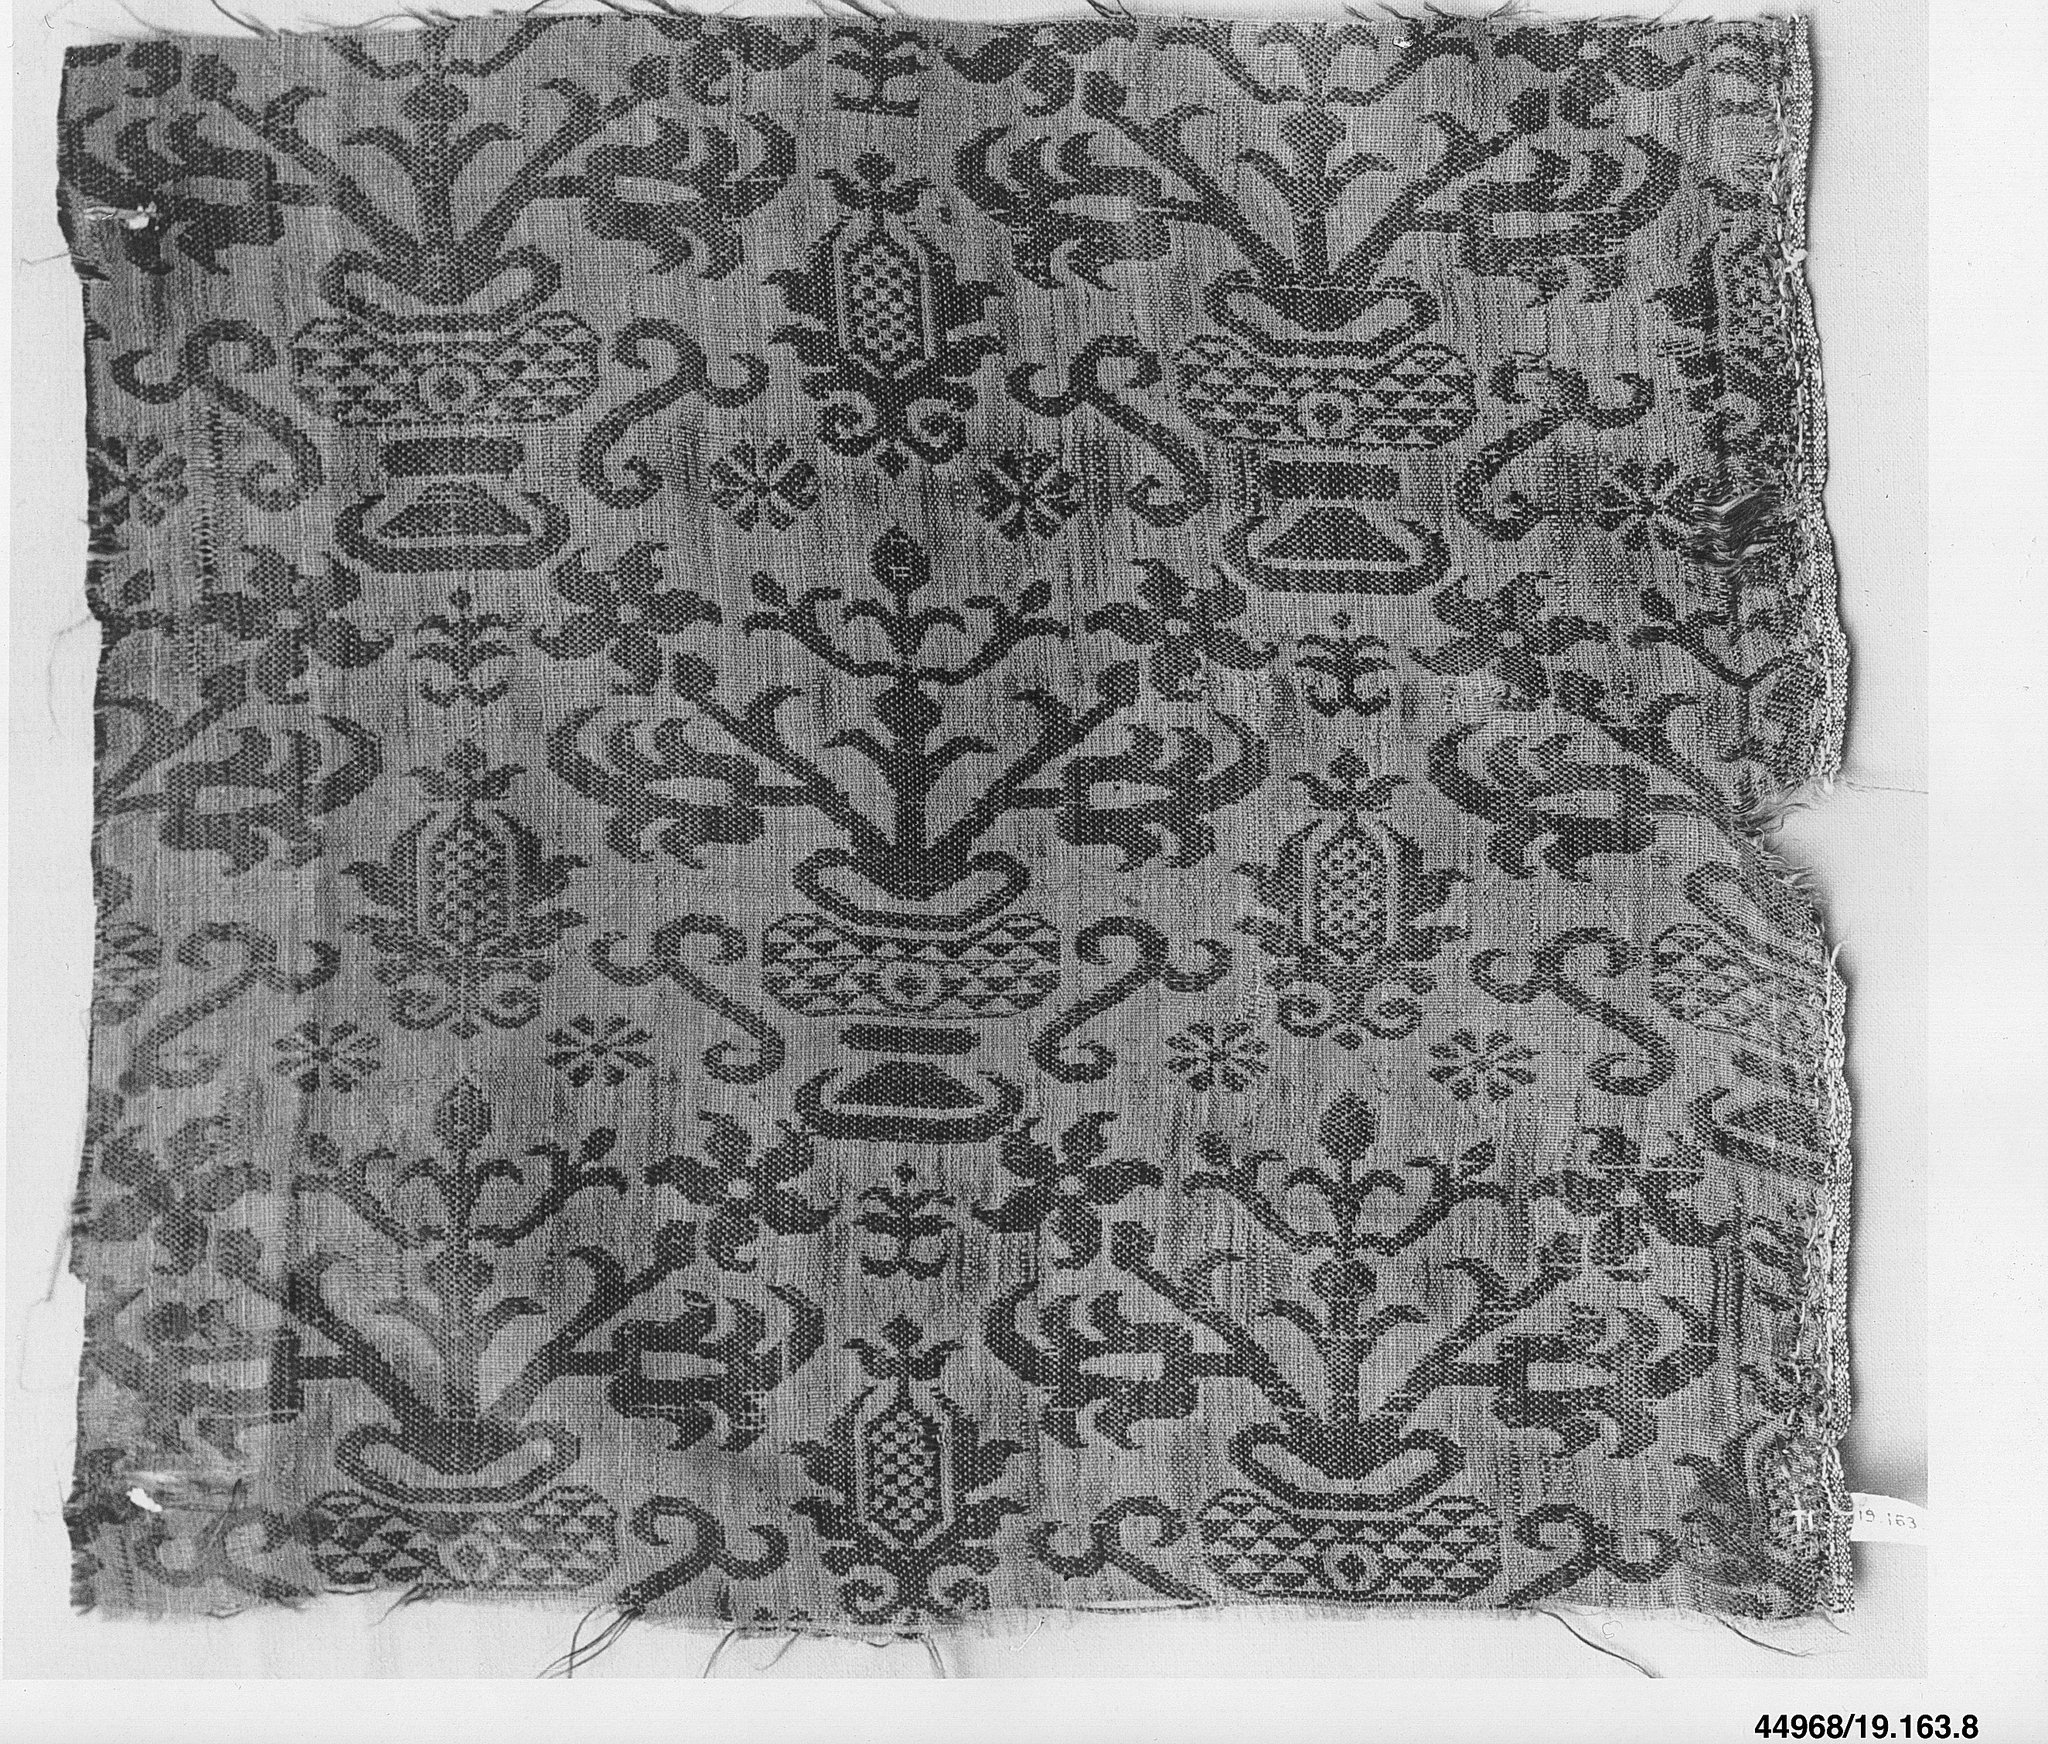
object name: piece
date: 1601-1700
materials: silk